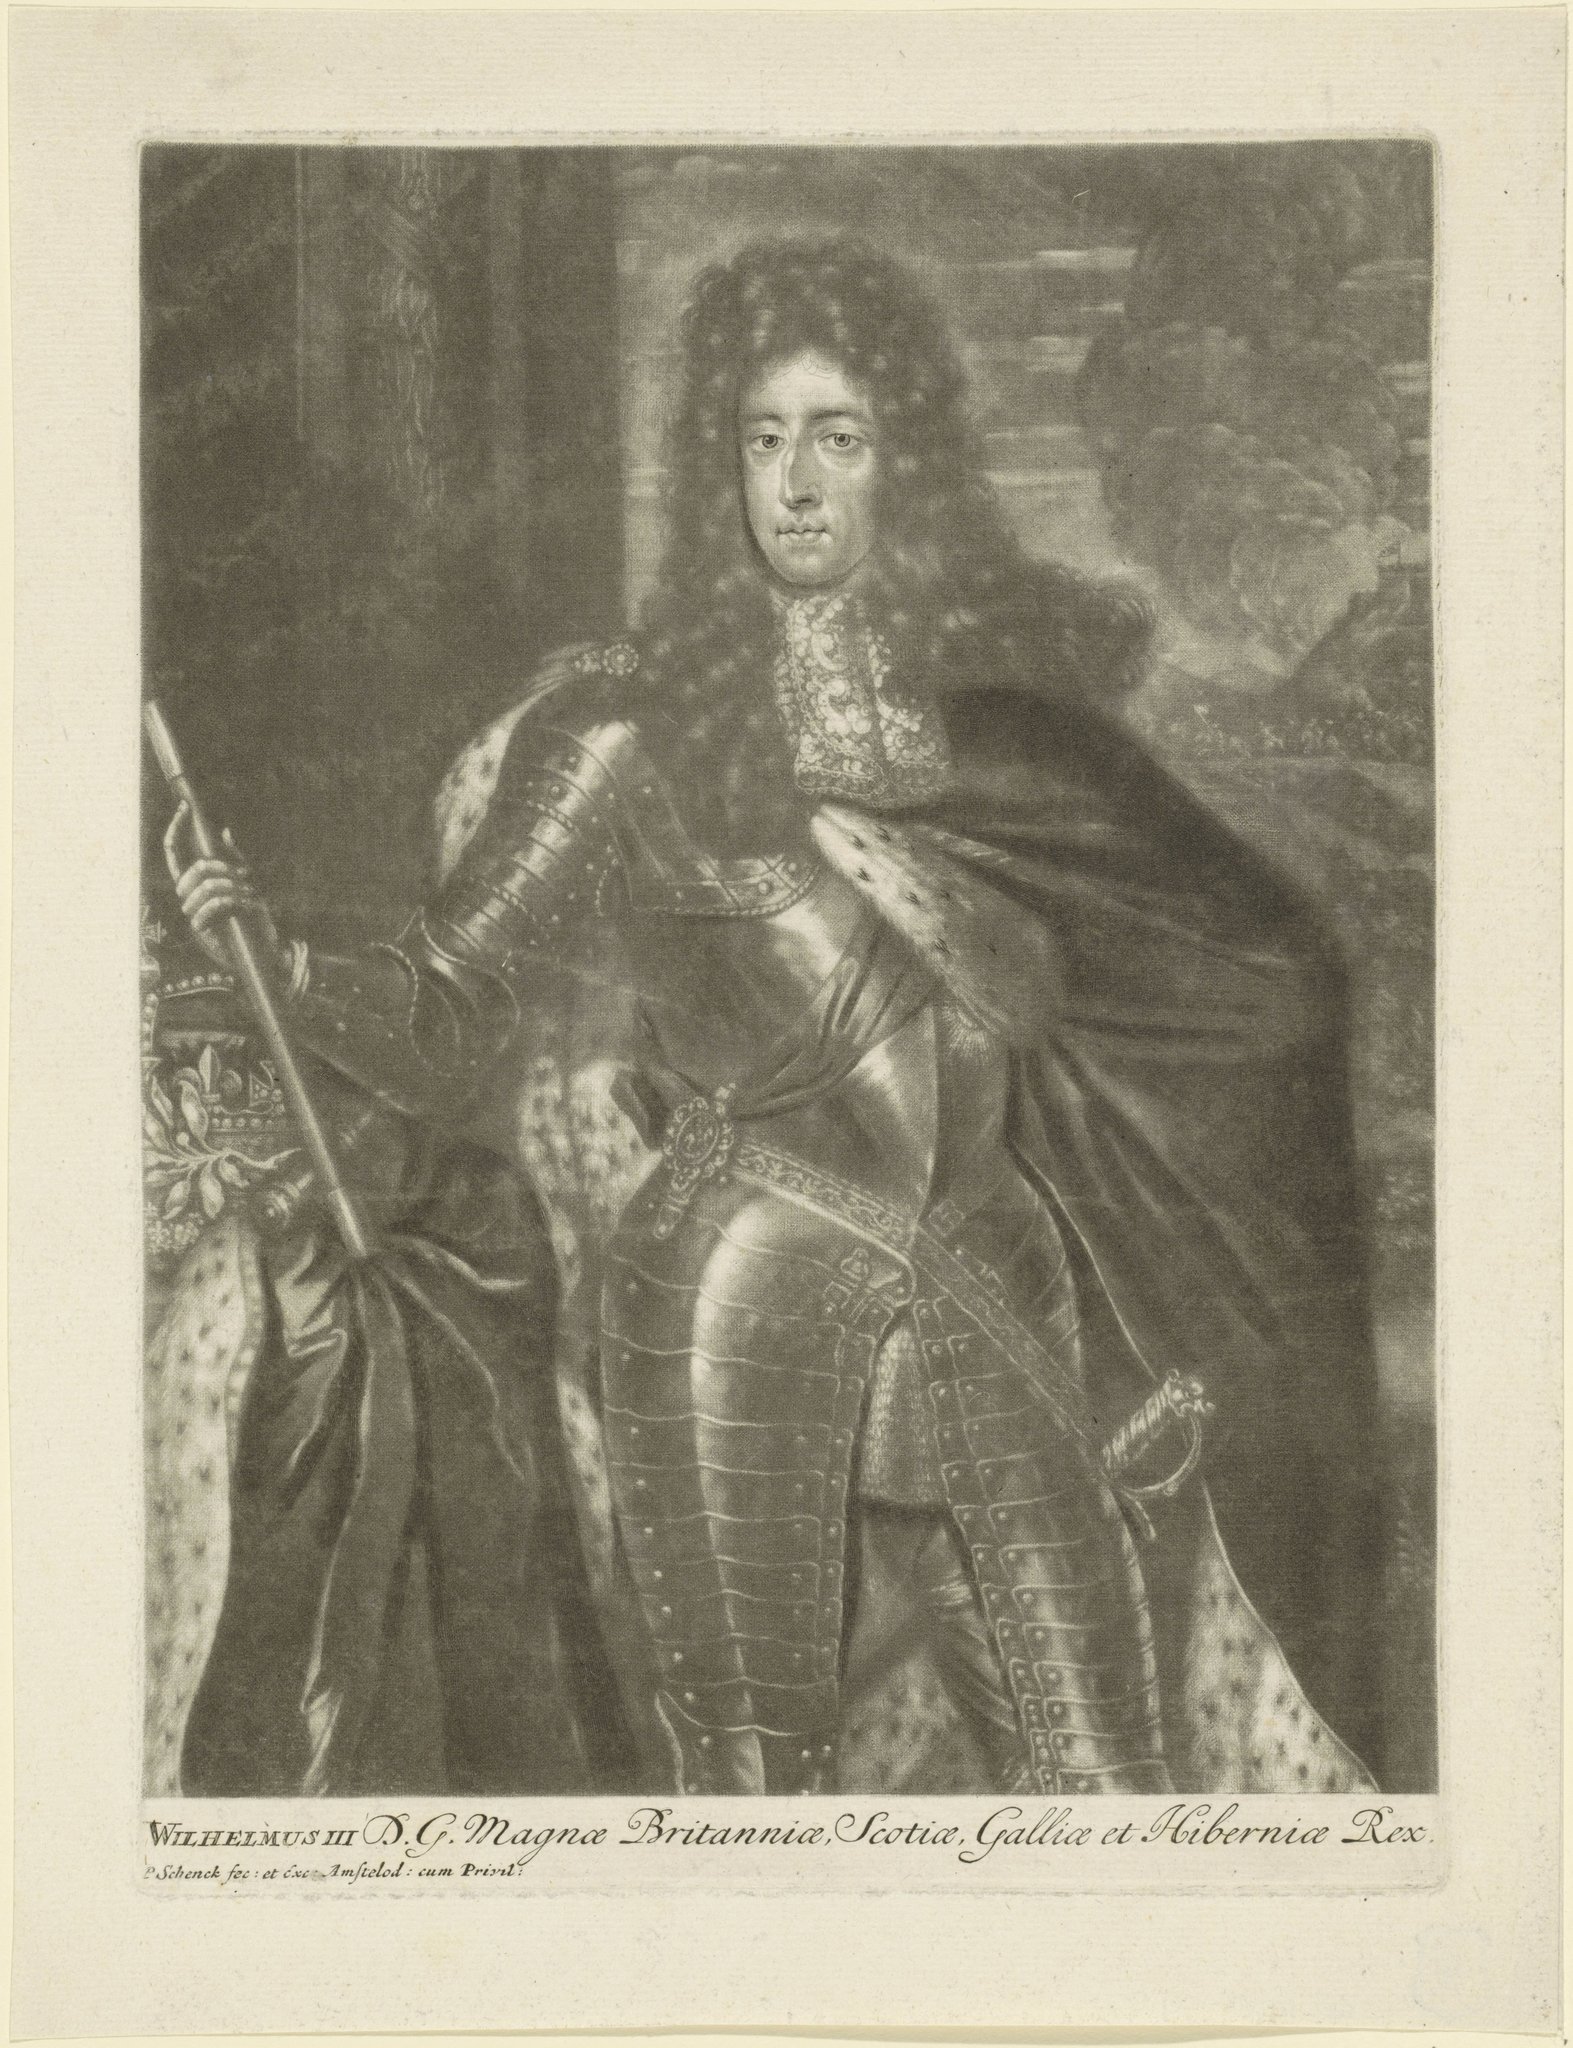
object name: print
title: Portret van Willem III, prins van Oranje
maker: pieter schenk (i)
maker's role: print maker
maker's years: 1660-1711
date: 1688-1711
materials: paper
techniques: engraving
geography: amsterdam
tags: the hague, william iii (prince of orange and king of england, scotland, and ireland)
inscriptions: collector's mark: Lugt 963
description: De hier vermelde titel verwijst naar de hoogst verkregen titel van de geportretteerde, niet per se naar de titel die de geportretteerde op deze voorstelling draagt.